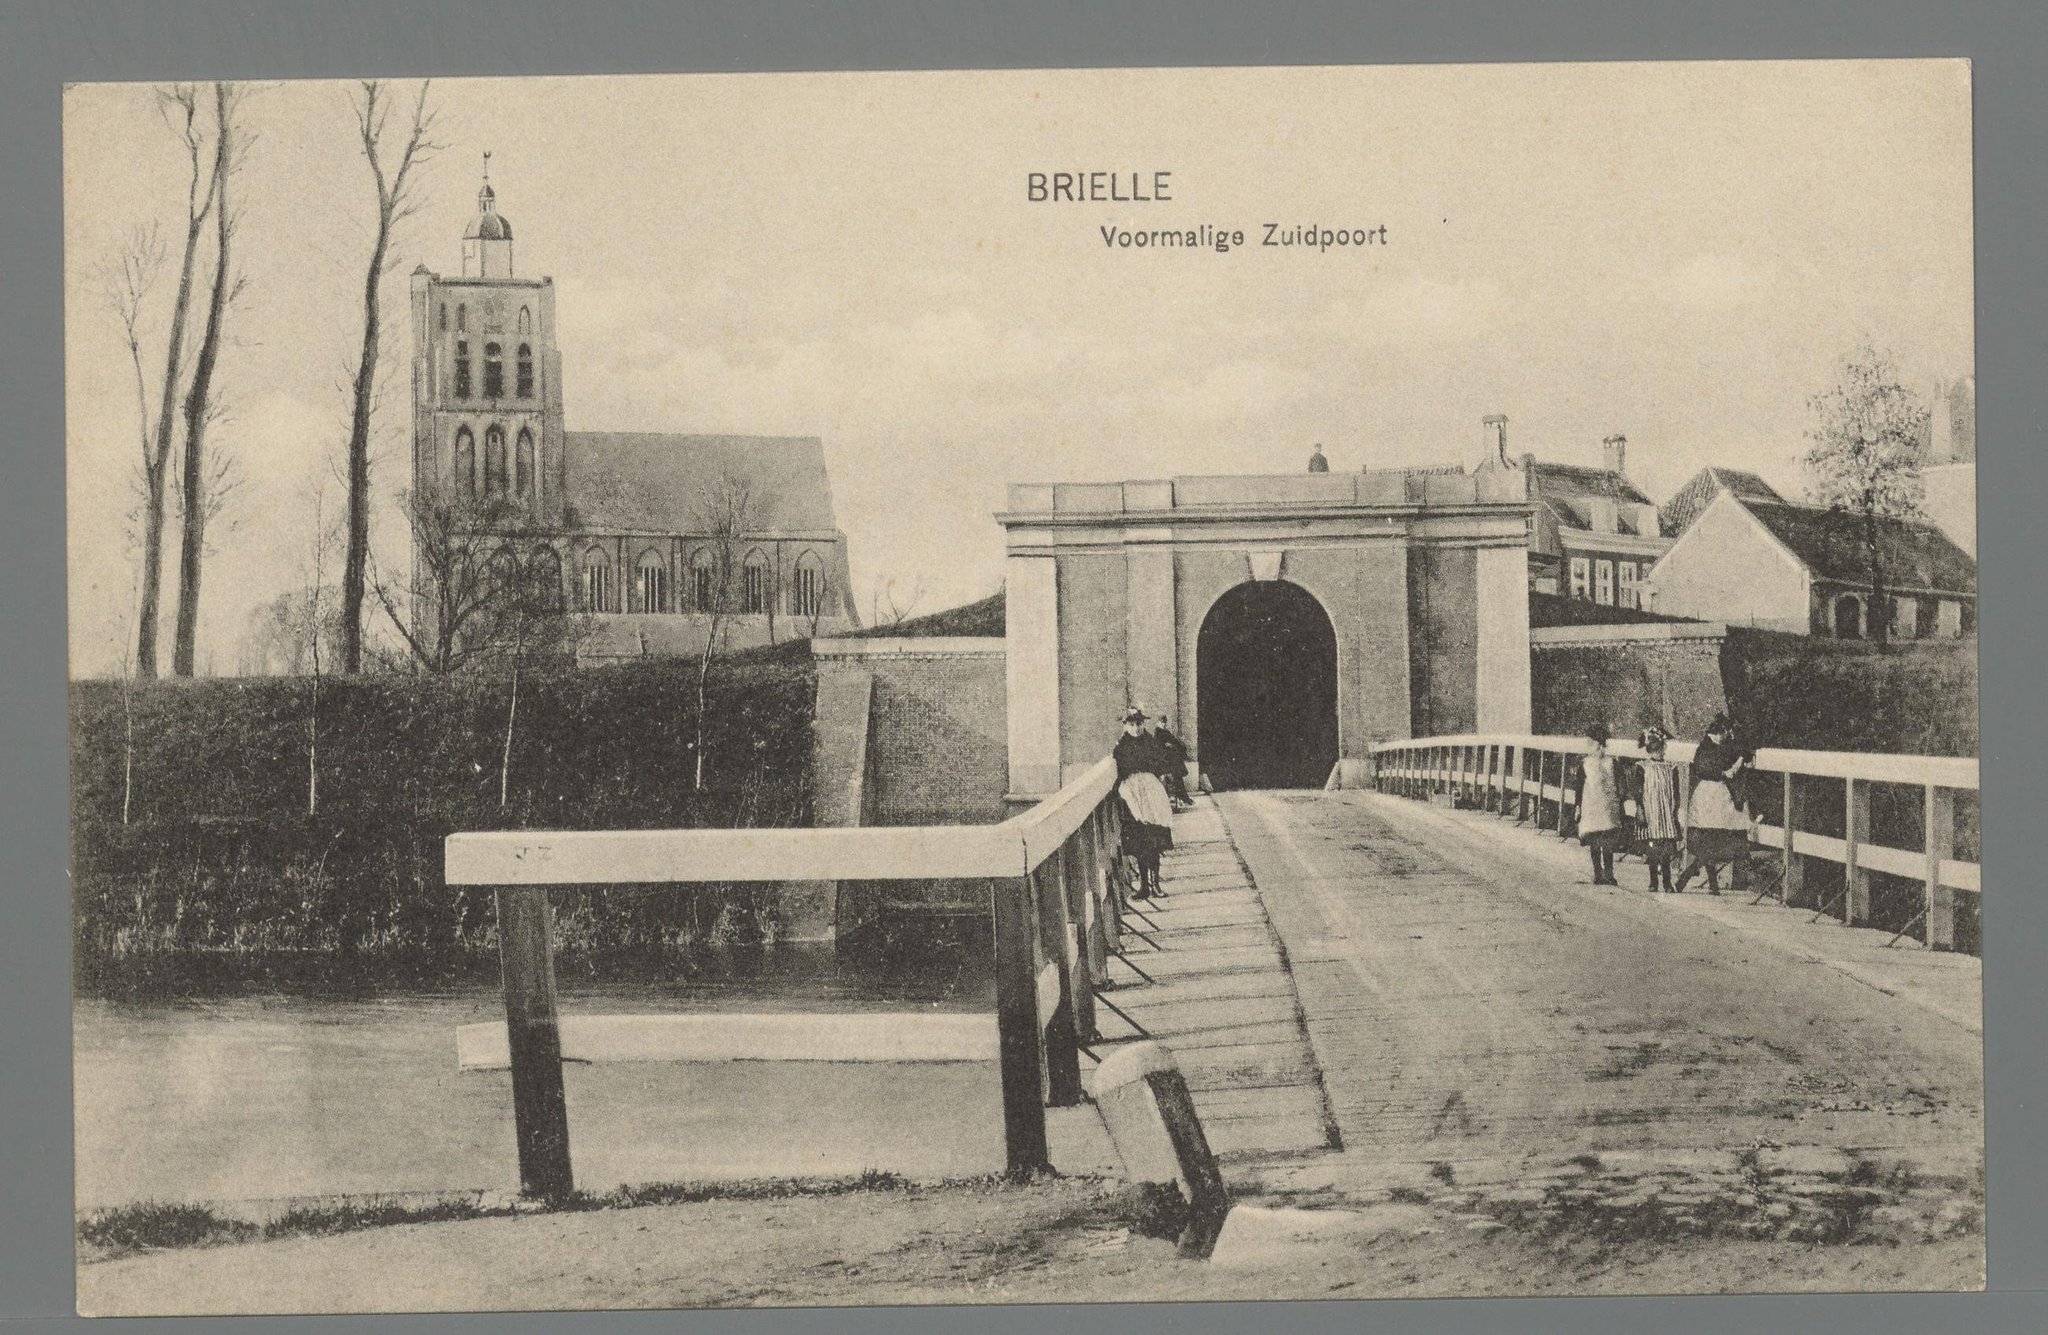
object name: ansichtkaart, prentbriefkaart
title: Brielle. Voormalige Zuidpoort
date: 1913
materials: cardboard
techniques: photograph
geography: brielle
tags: church (exterior), bridge in city across river, canal, etc., city-gate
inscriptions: date